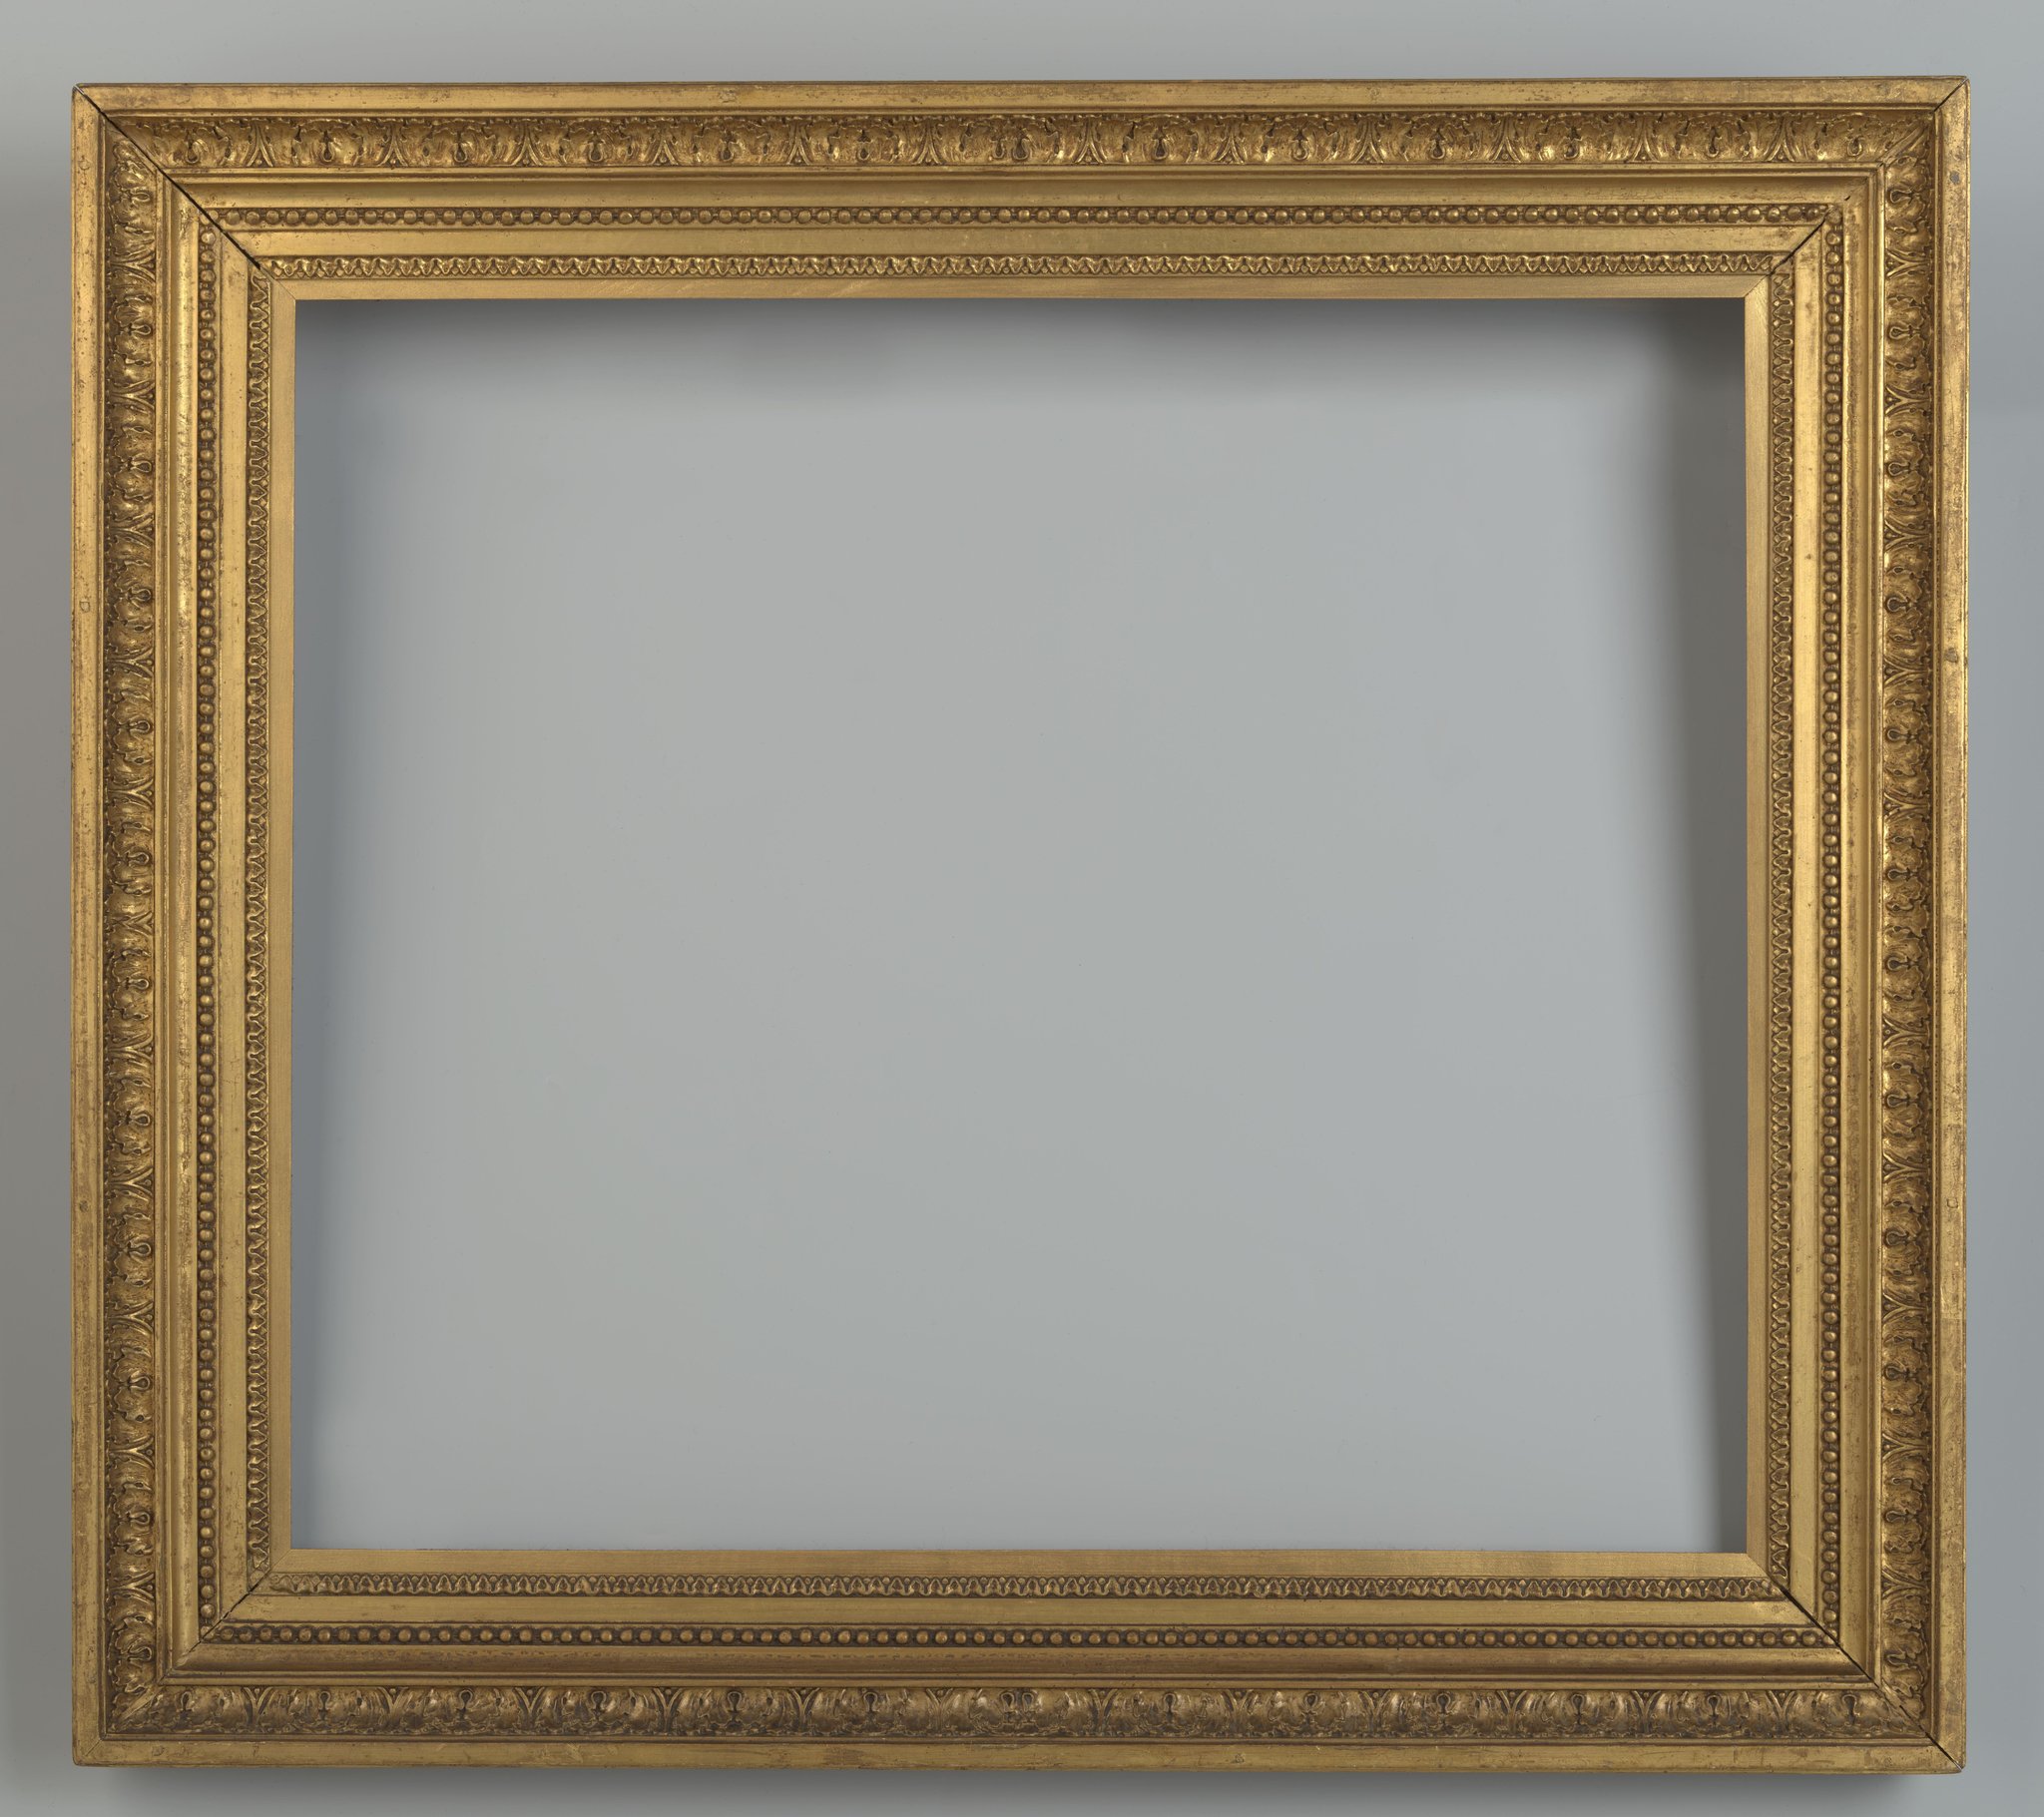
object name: frame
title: Vergulde empire lijst met acanthusbladeren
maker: Anonymous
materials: wood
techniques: gilding